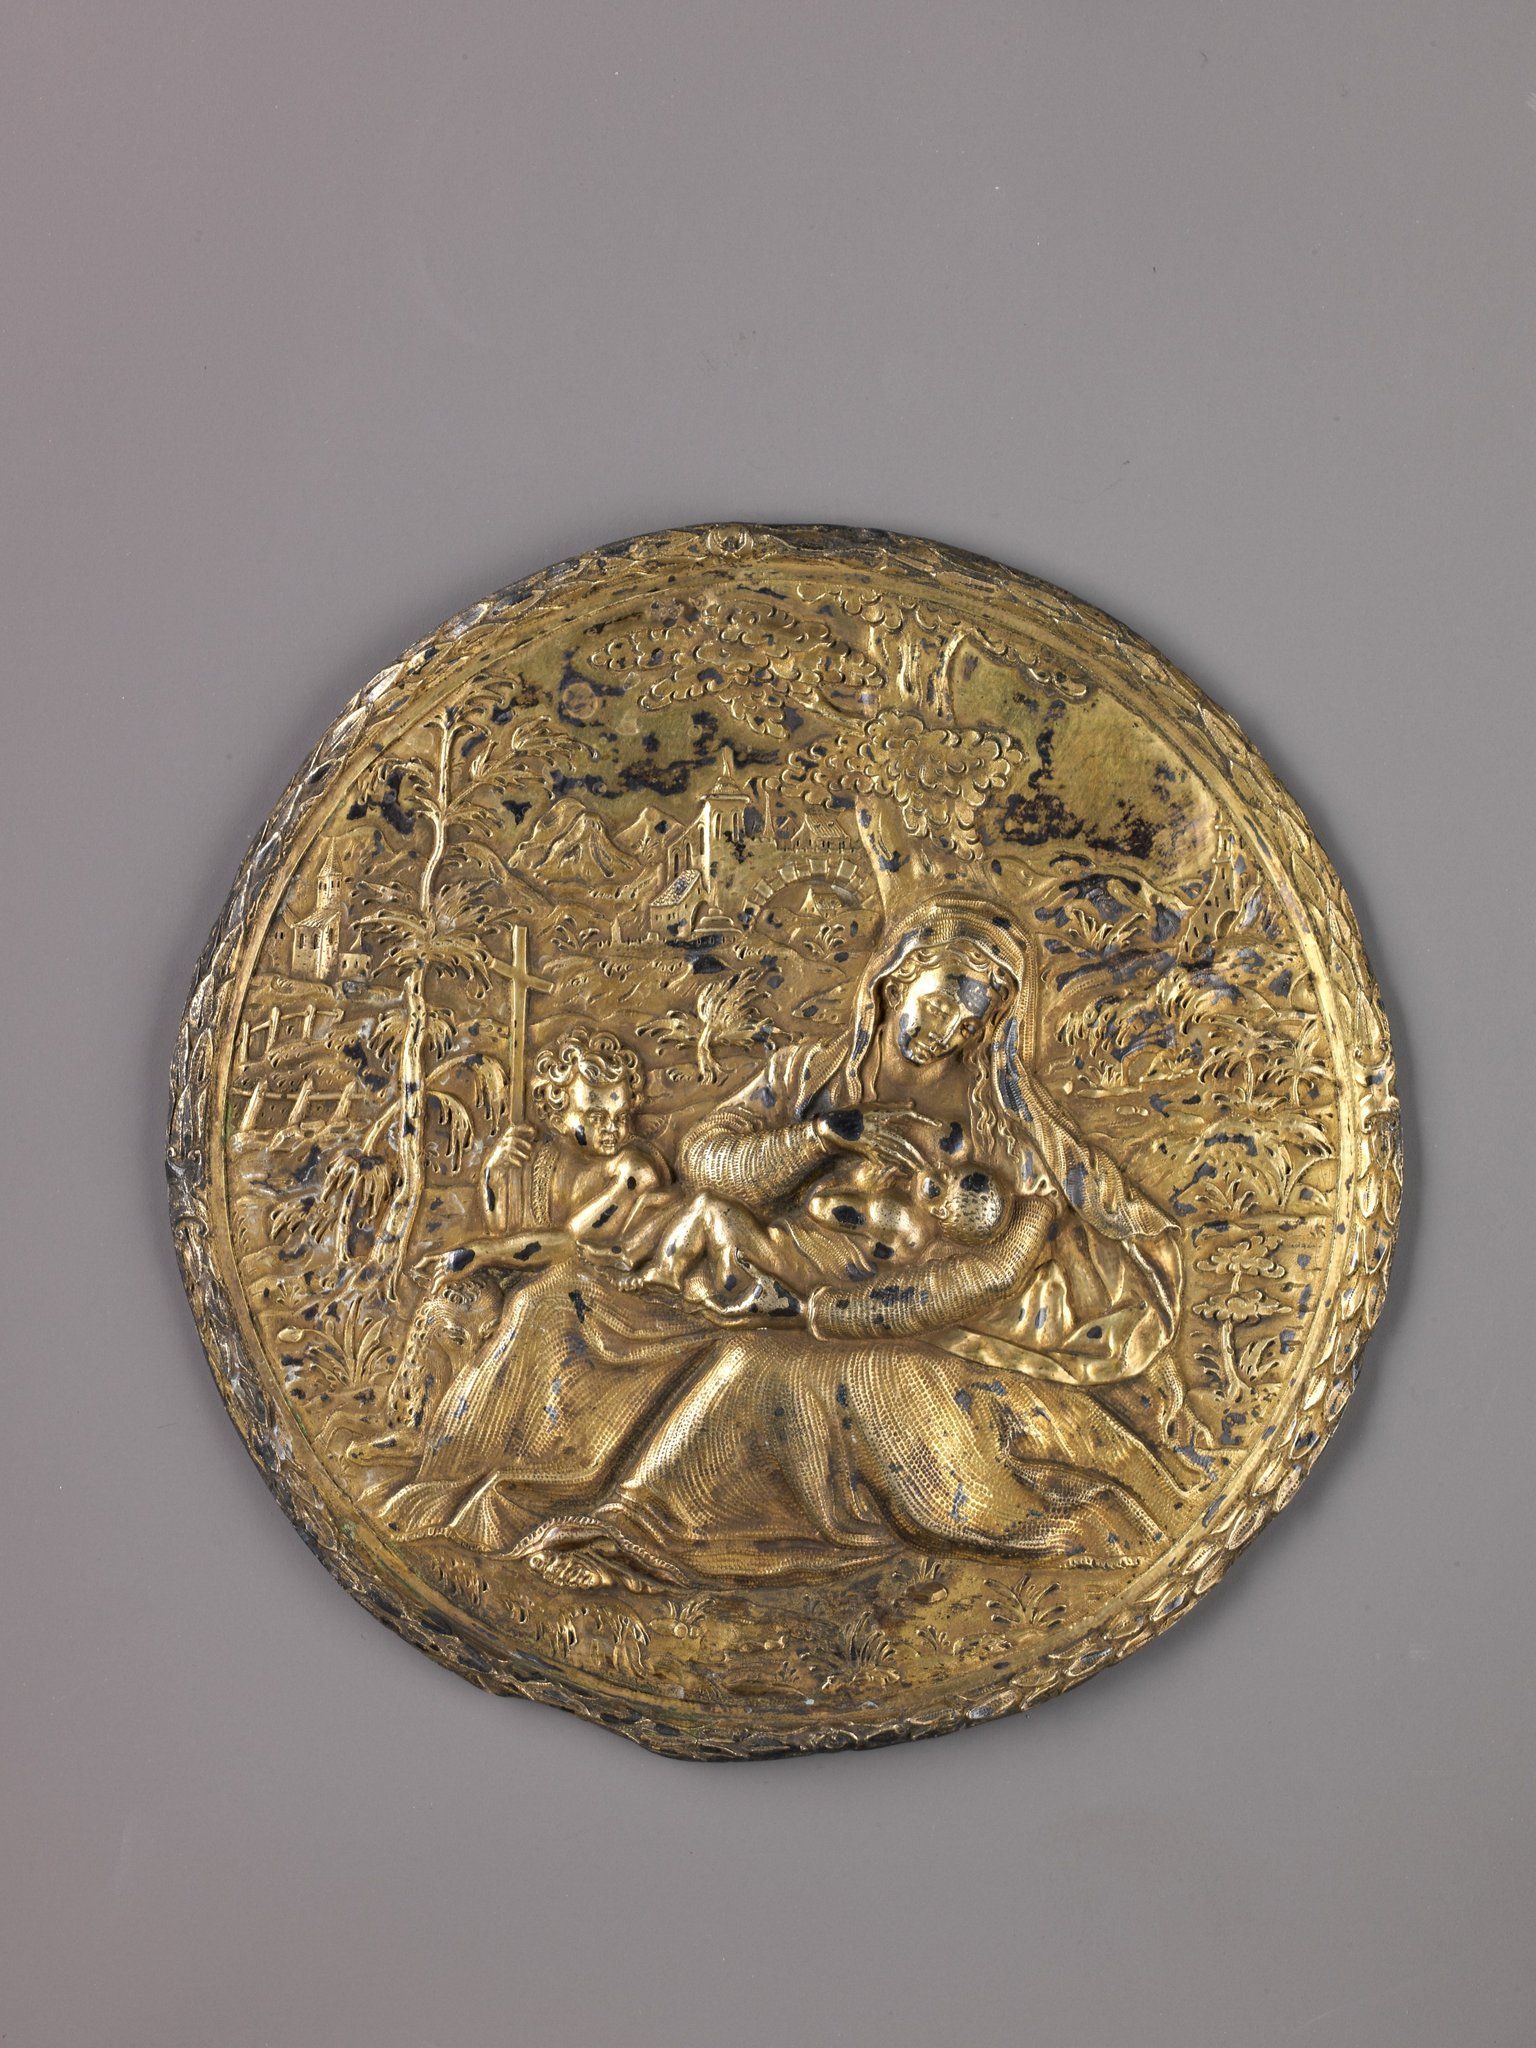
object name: plaquette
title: Virgin and Child with St. John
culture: dutch or south german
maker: arent van bolten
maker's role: artist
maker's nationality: netherlandish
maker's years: 1573-1633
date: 1625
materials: silver gilt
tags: madonna and child,saint john the baptist,nursing